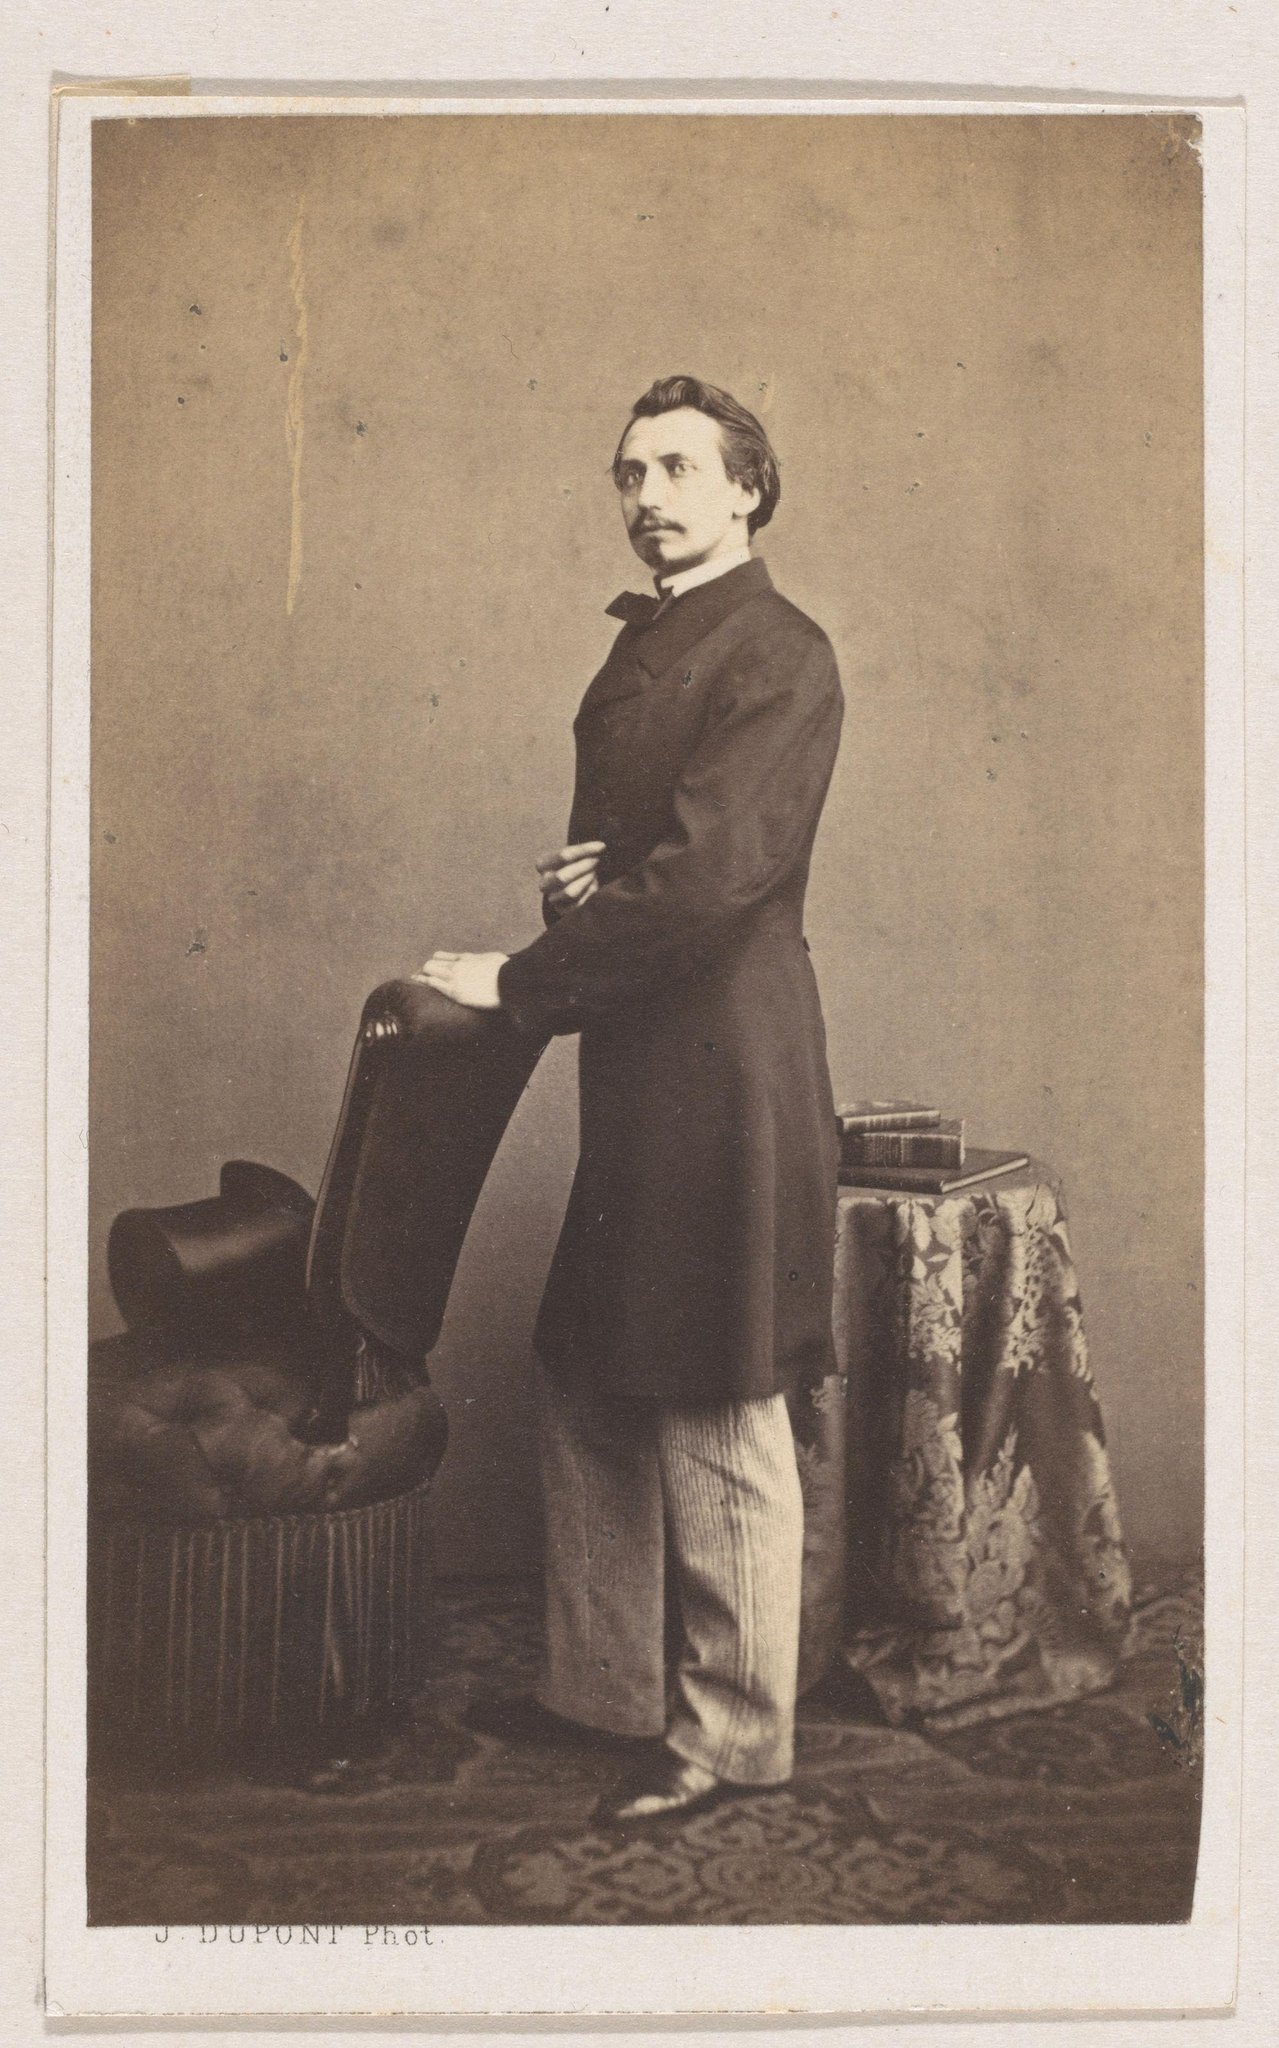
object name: carte de visite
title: L'École d'Anvers. Portraits biographies cartes de visite. Collection Dupont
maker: joseph dupont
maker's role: fotograaf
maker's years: 1818-1901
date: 1861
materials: cardboard, paper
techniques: albumen print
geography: antwerp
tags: antwerp, print maker, joseph wildiers, historical persons, portrait, self-portrait of painter, portrait, self-portrait of artist, portrait, self-portrait of draughtsman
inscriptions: inscription: ‘Wildiers’, inscription: ‘ETABLISSEMENT PHOTOGRAPHIQUE/ de/ J. DUPONT/ Place de Meir 32/ ANVERS/ Maison fondée en 1853’